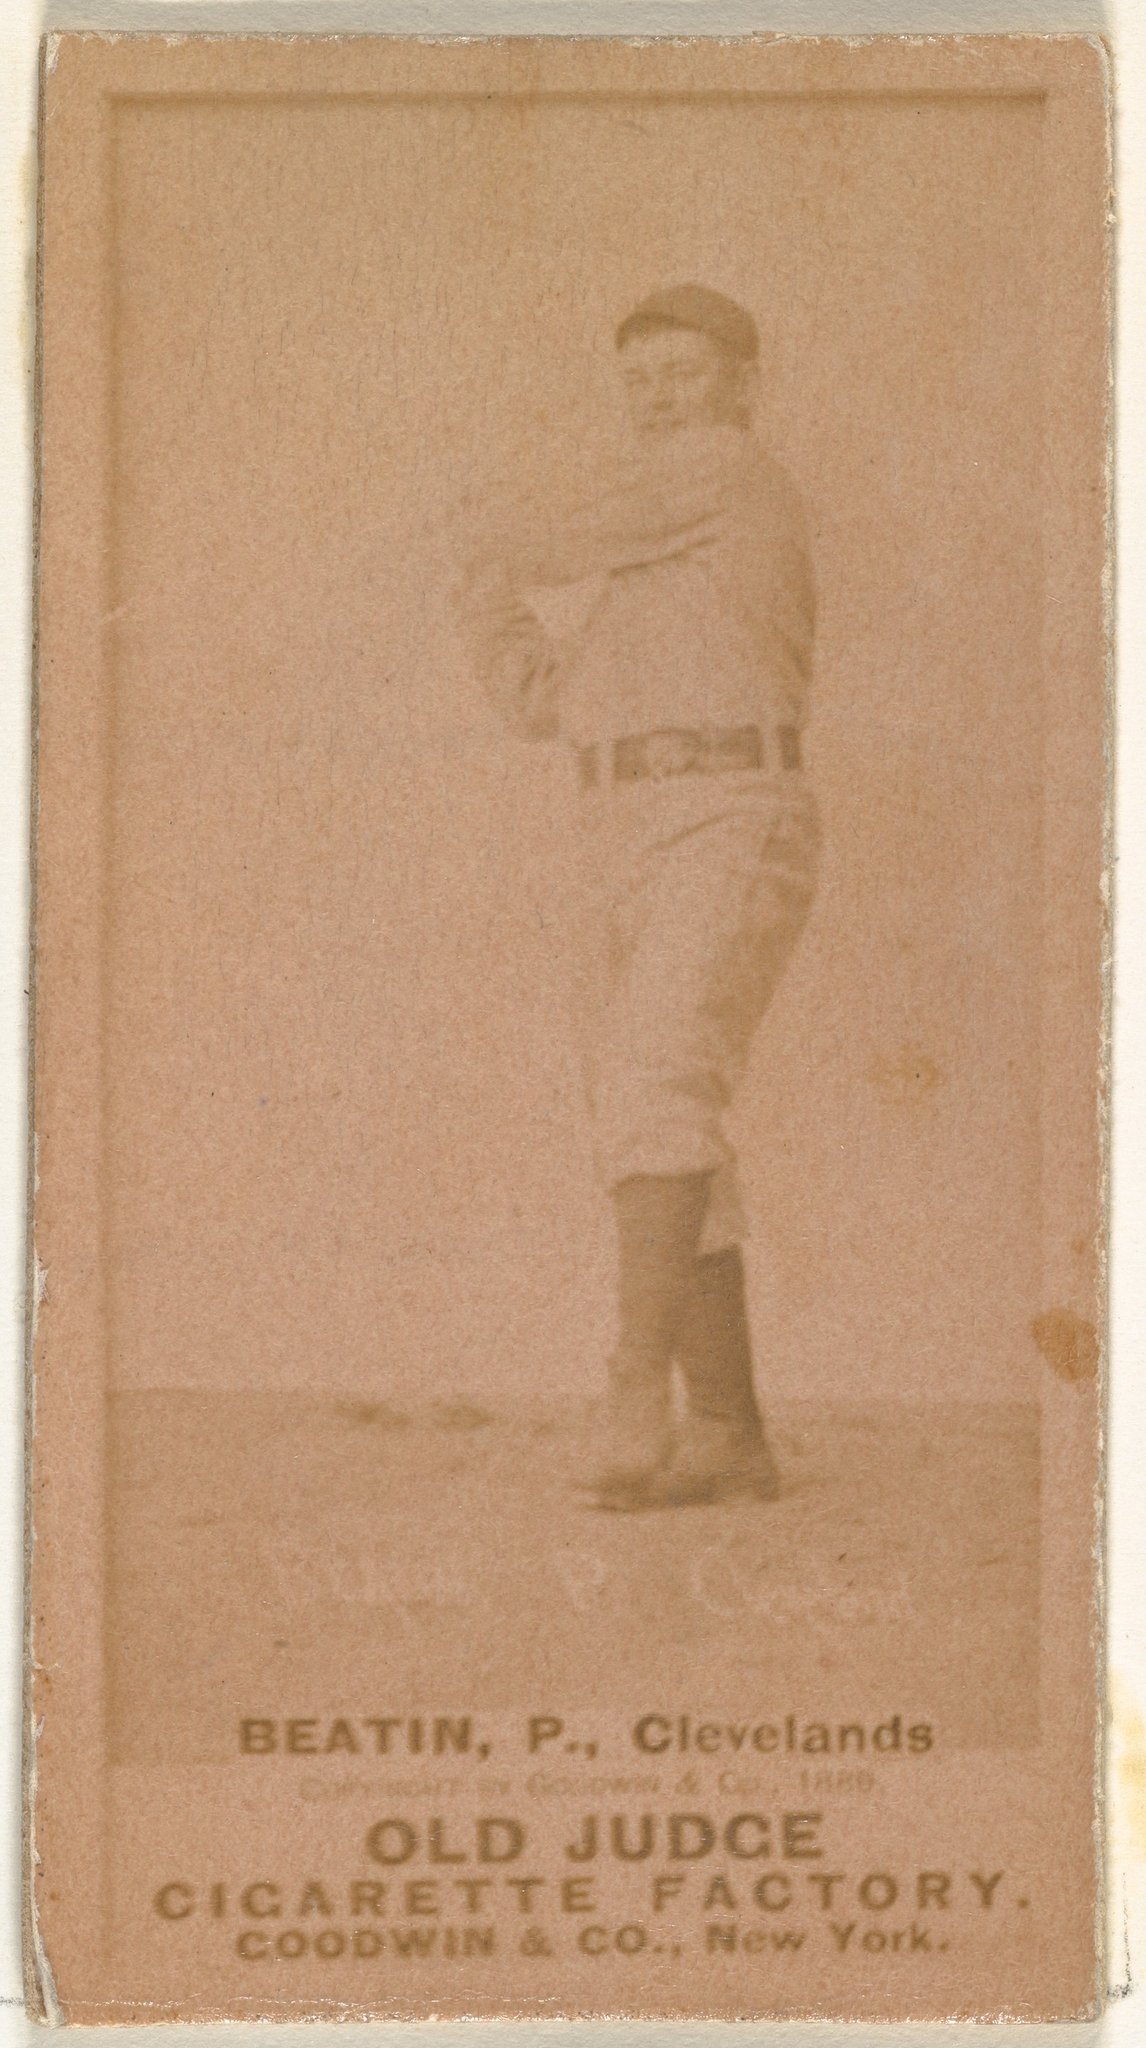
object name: baseball card, photograph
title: Ebenezer Ambrose "Ed" Beatin, Pitcher, Cleveland, from the Old Judge series (N172) for Old Judge Cigarettes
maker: goodwin & company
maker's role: publisher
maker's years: 1850-1950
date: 1887-1890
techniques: albumen silver print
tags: men,portraits,baseball,athletes